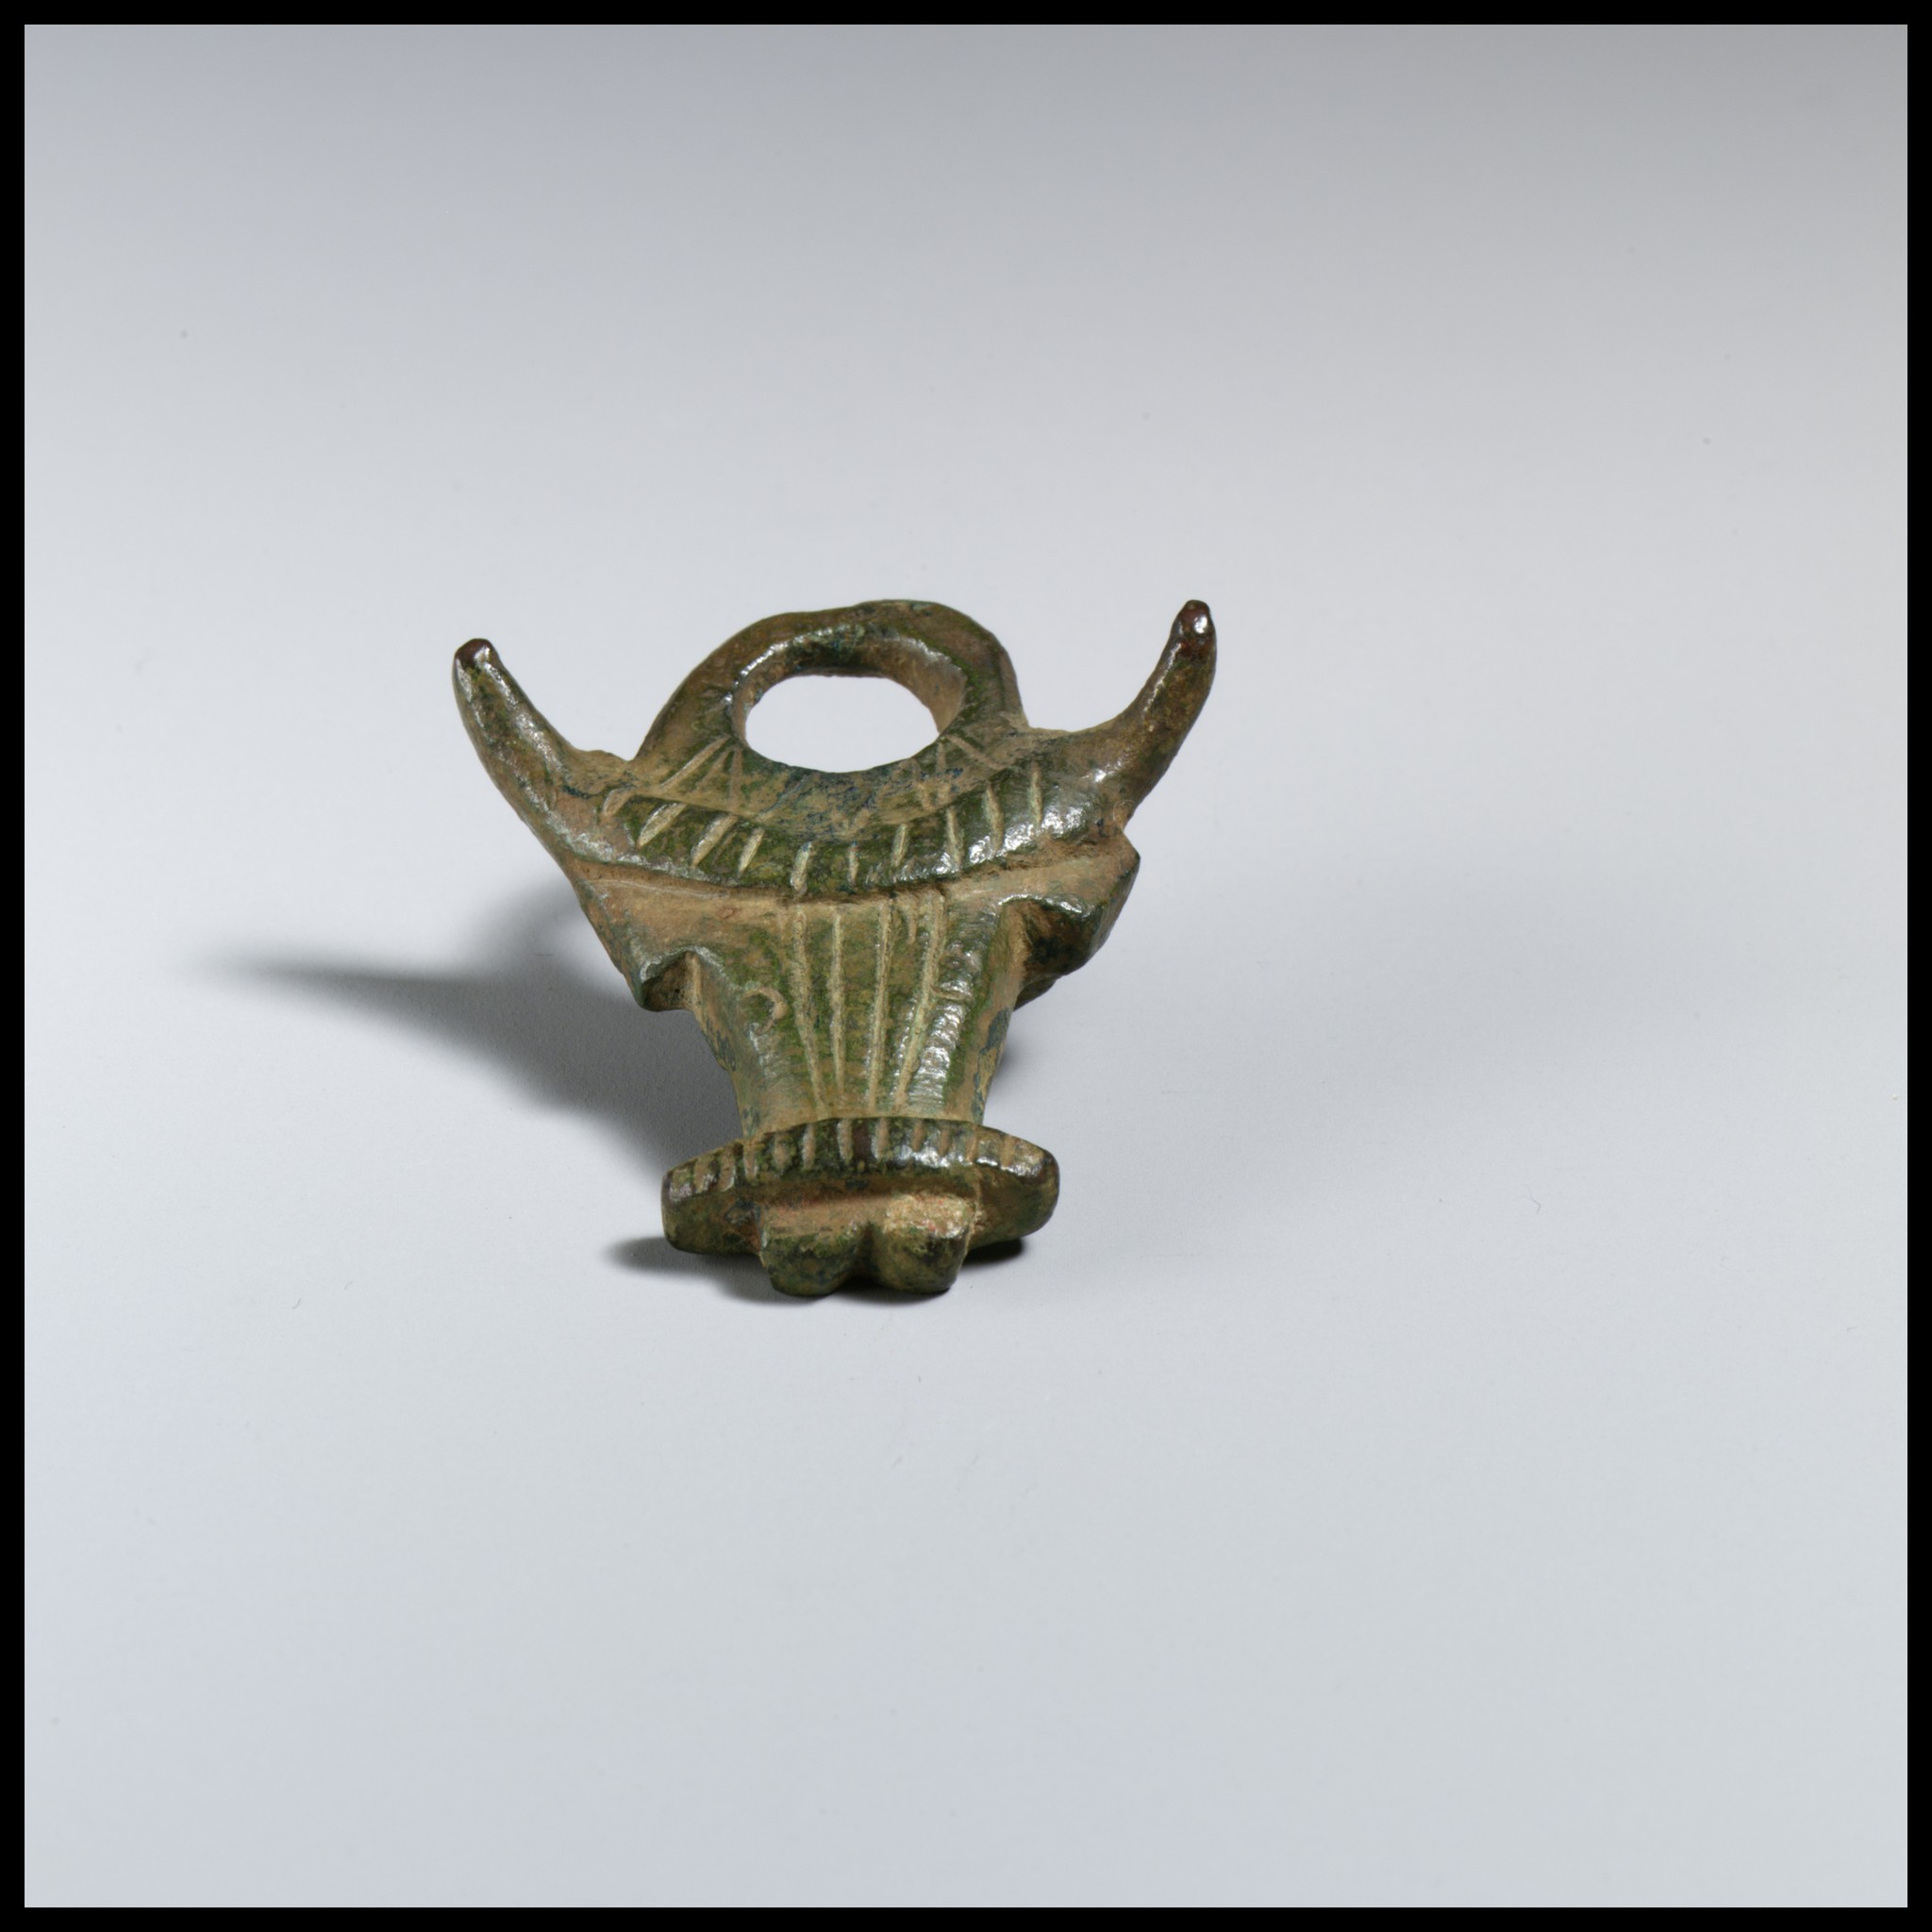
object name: necklace, bead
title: Amulet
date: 7000 BCE-330 CE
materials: bronze